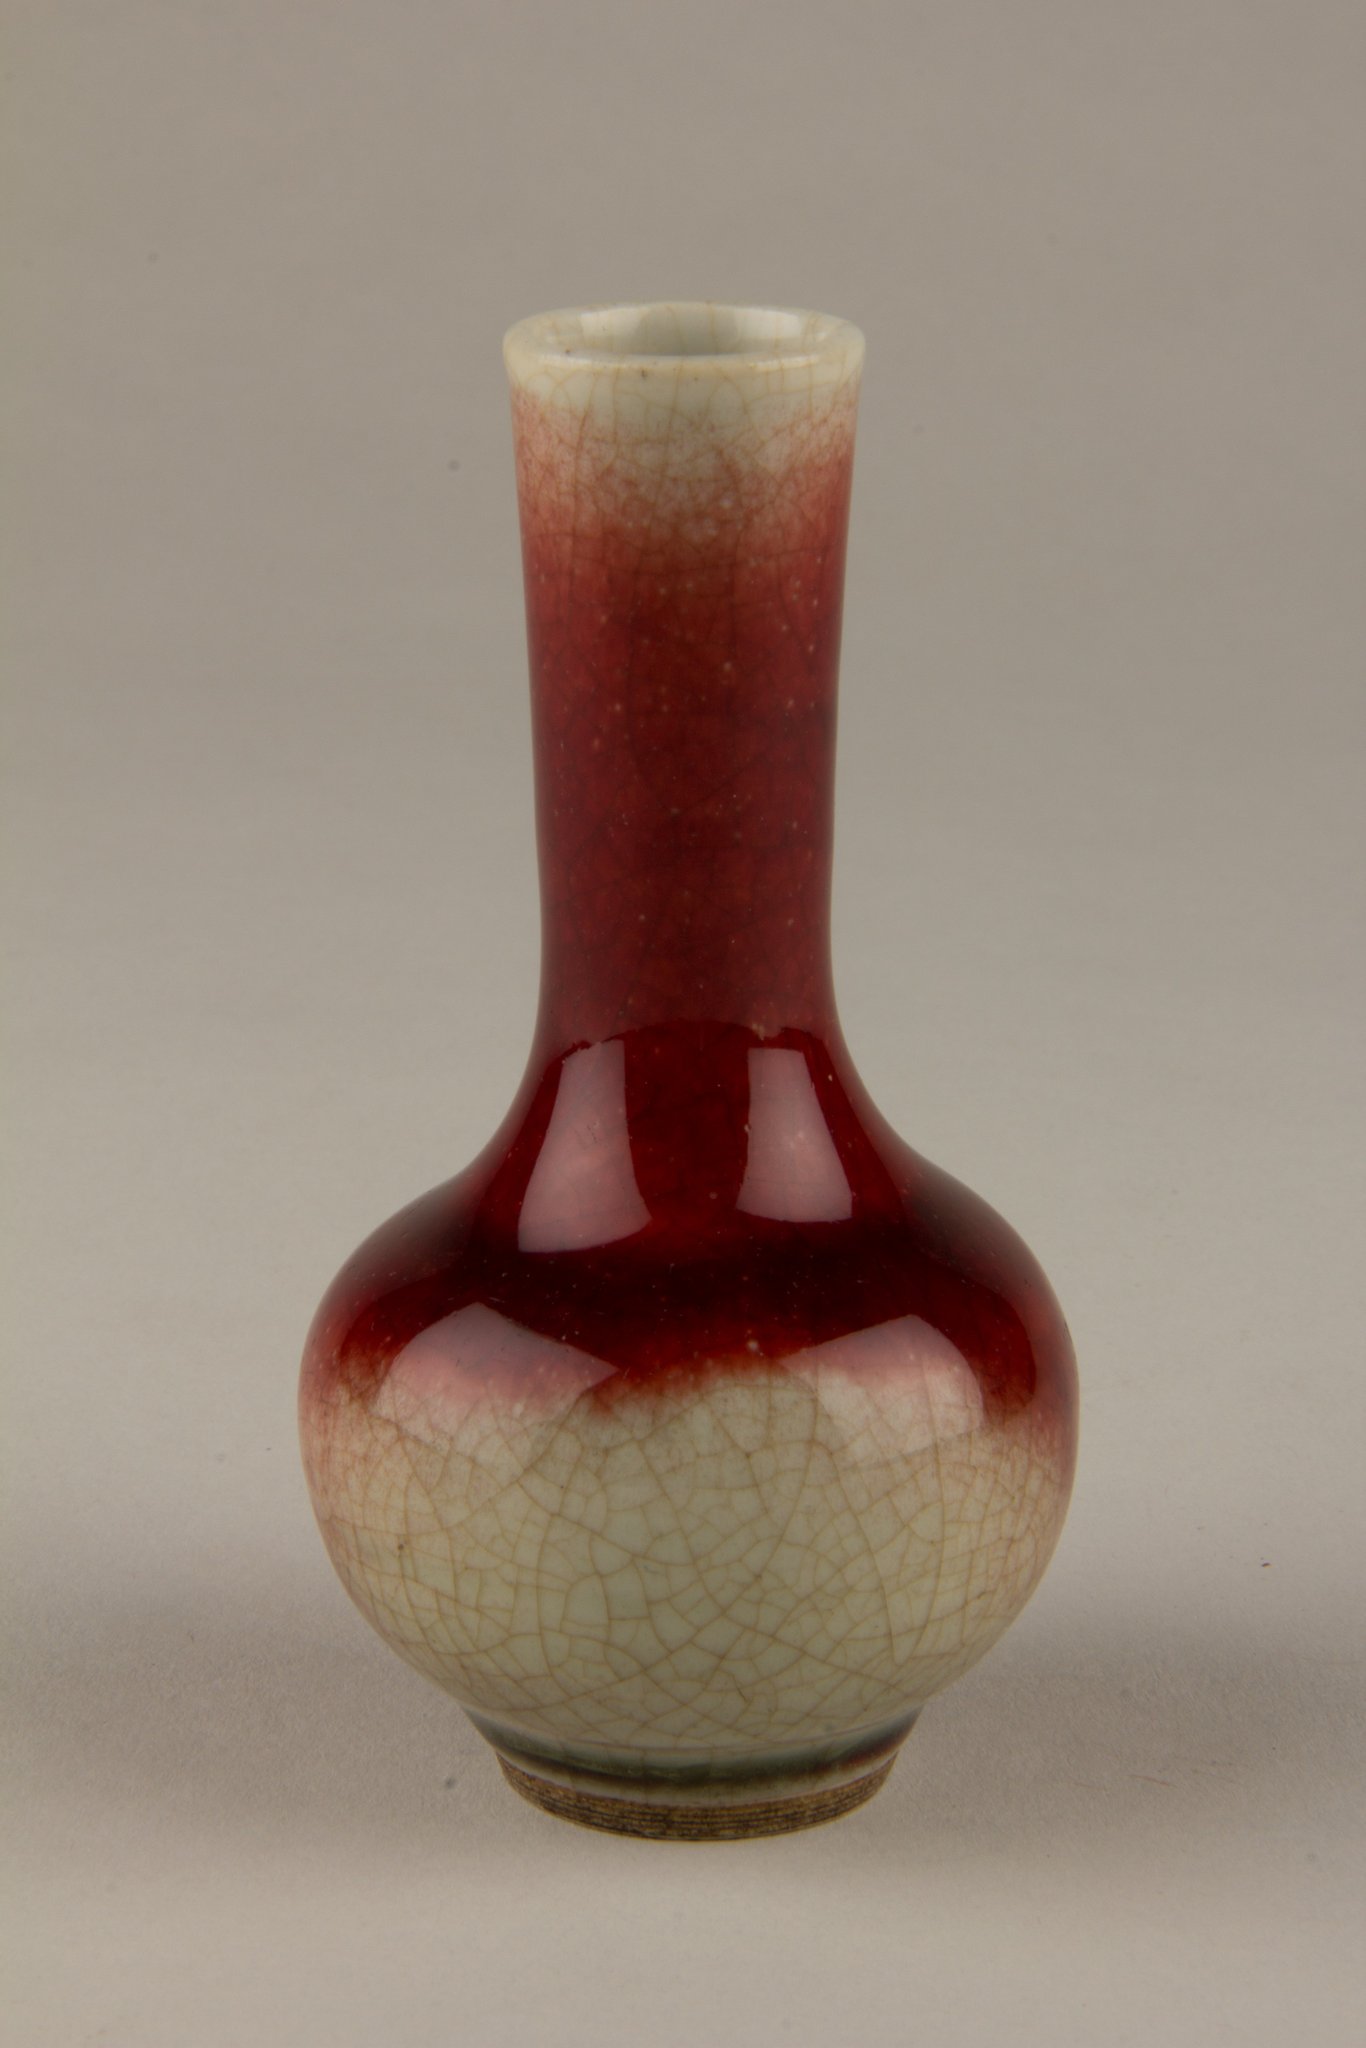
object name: bottle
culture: chinese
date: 1662-1722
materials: porcelain